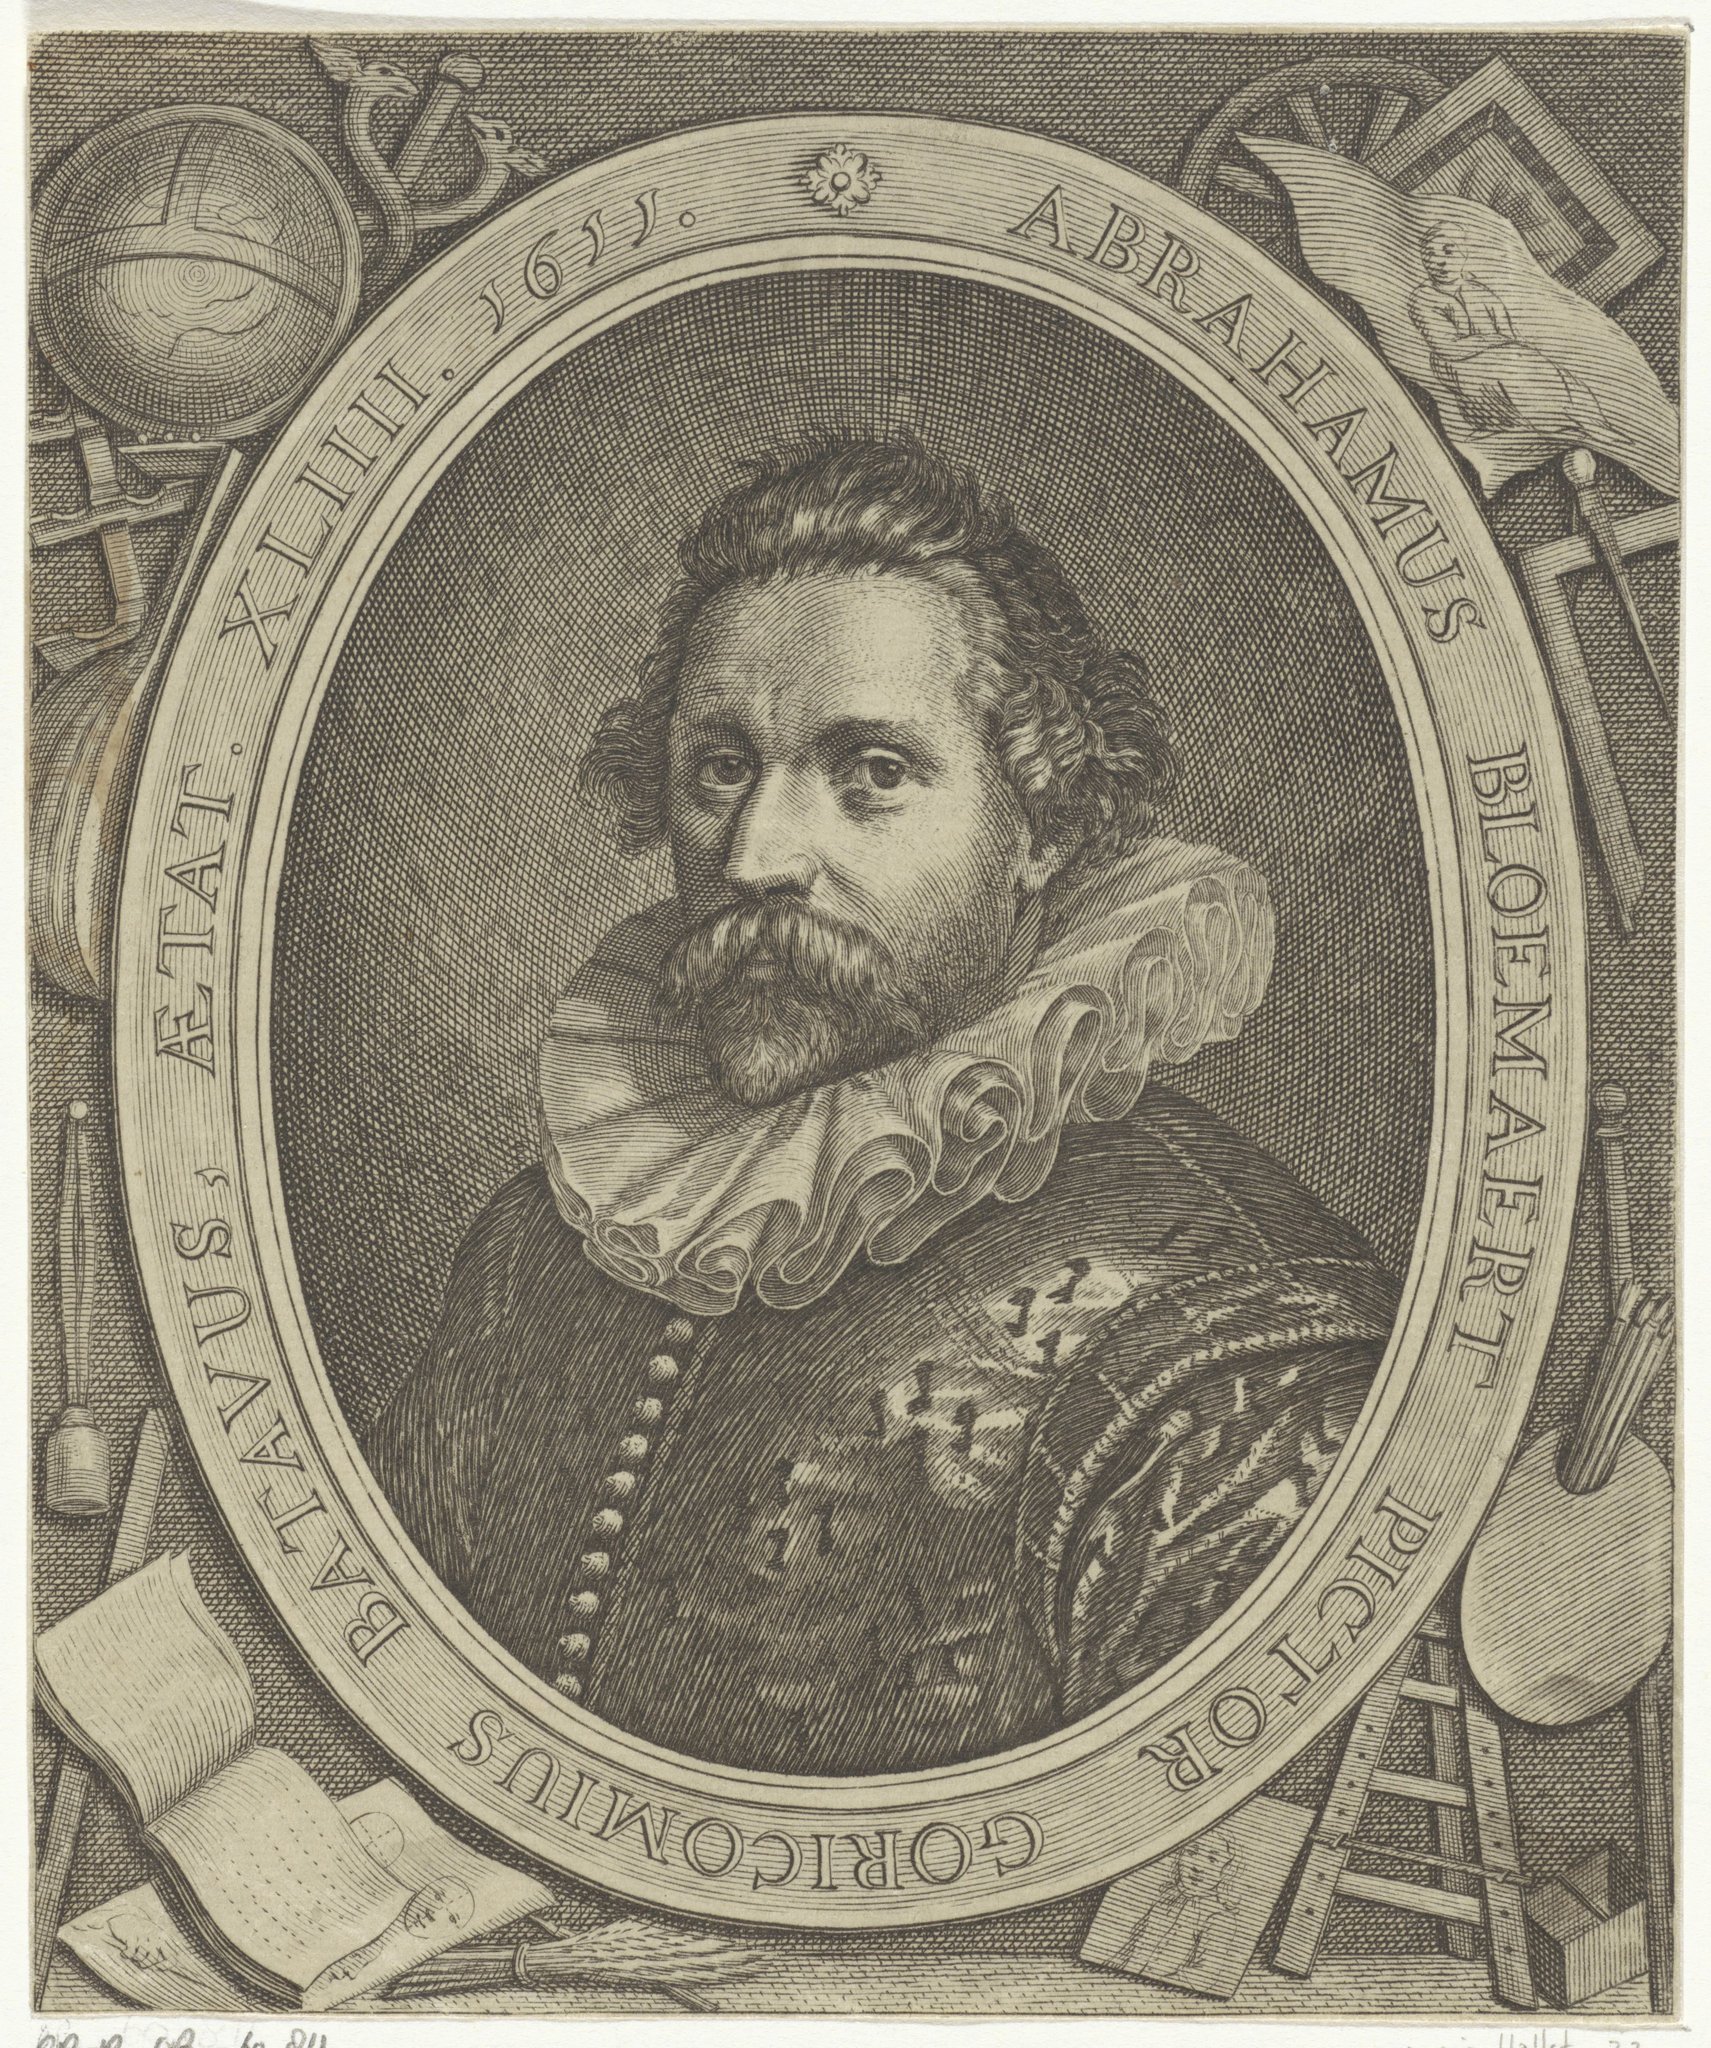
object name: print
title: Portret van Abraham Bloemaert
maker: Anonymous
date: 1611-1661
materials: paper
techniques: engraving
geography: netherlands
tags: utrecht, painter, print maker, draughtsman, abraham bloemaert, portrait, self-portrait of painter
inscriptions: collector's mark: Lugt 2228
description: Portret van schilder, tekenaar en prentmaker Abraham Bloemaert, op 44-jarige leeftijd. Naast de lijst attributen van de vrije kunsten. Onder andere een globe, mandoline en caduceus, meetinstrumenten, passer, palet en tekenboeken.